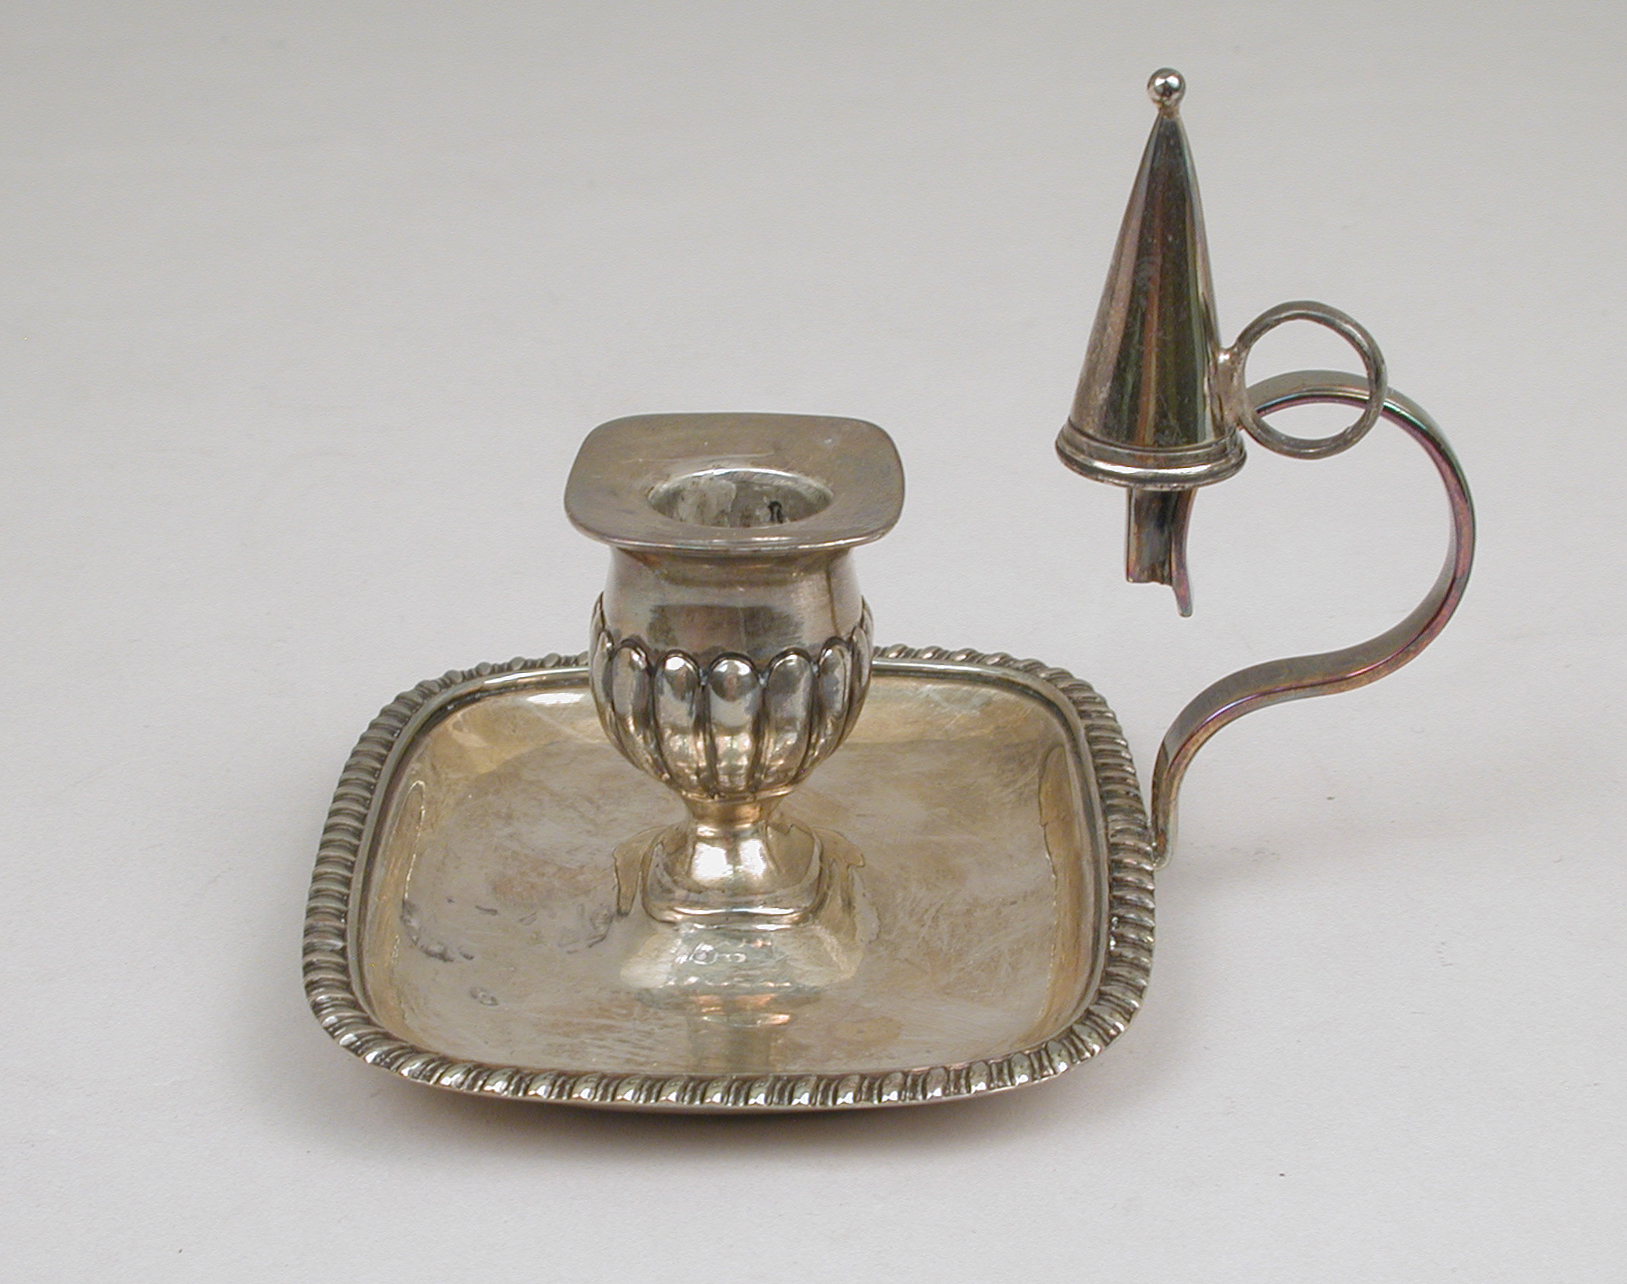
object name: chamber candlestick or taperstick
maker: christopher binger i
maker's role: maker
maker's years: 1775-1875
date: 1819-1820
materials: silver